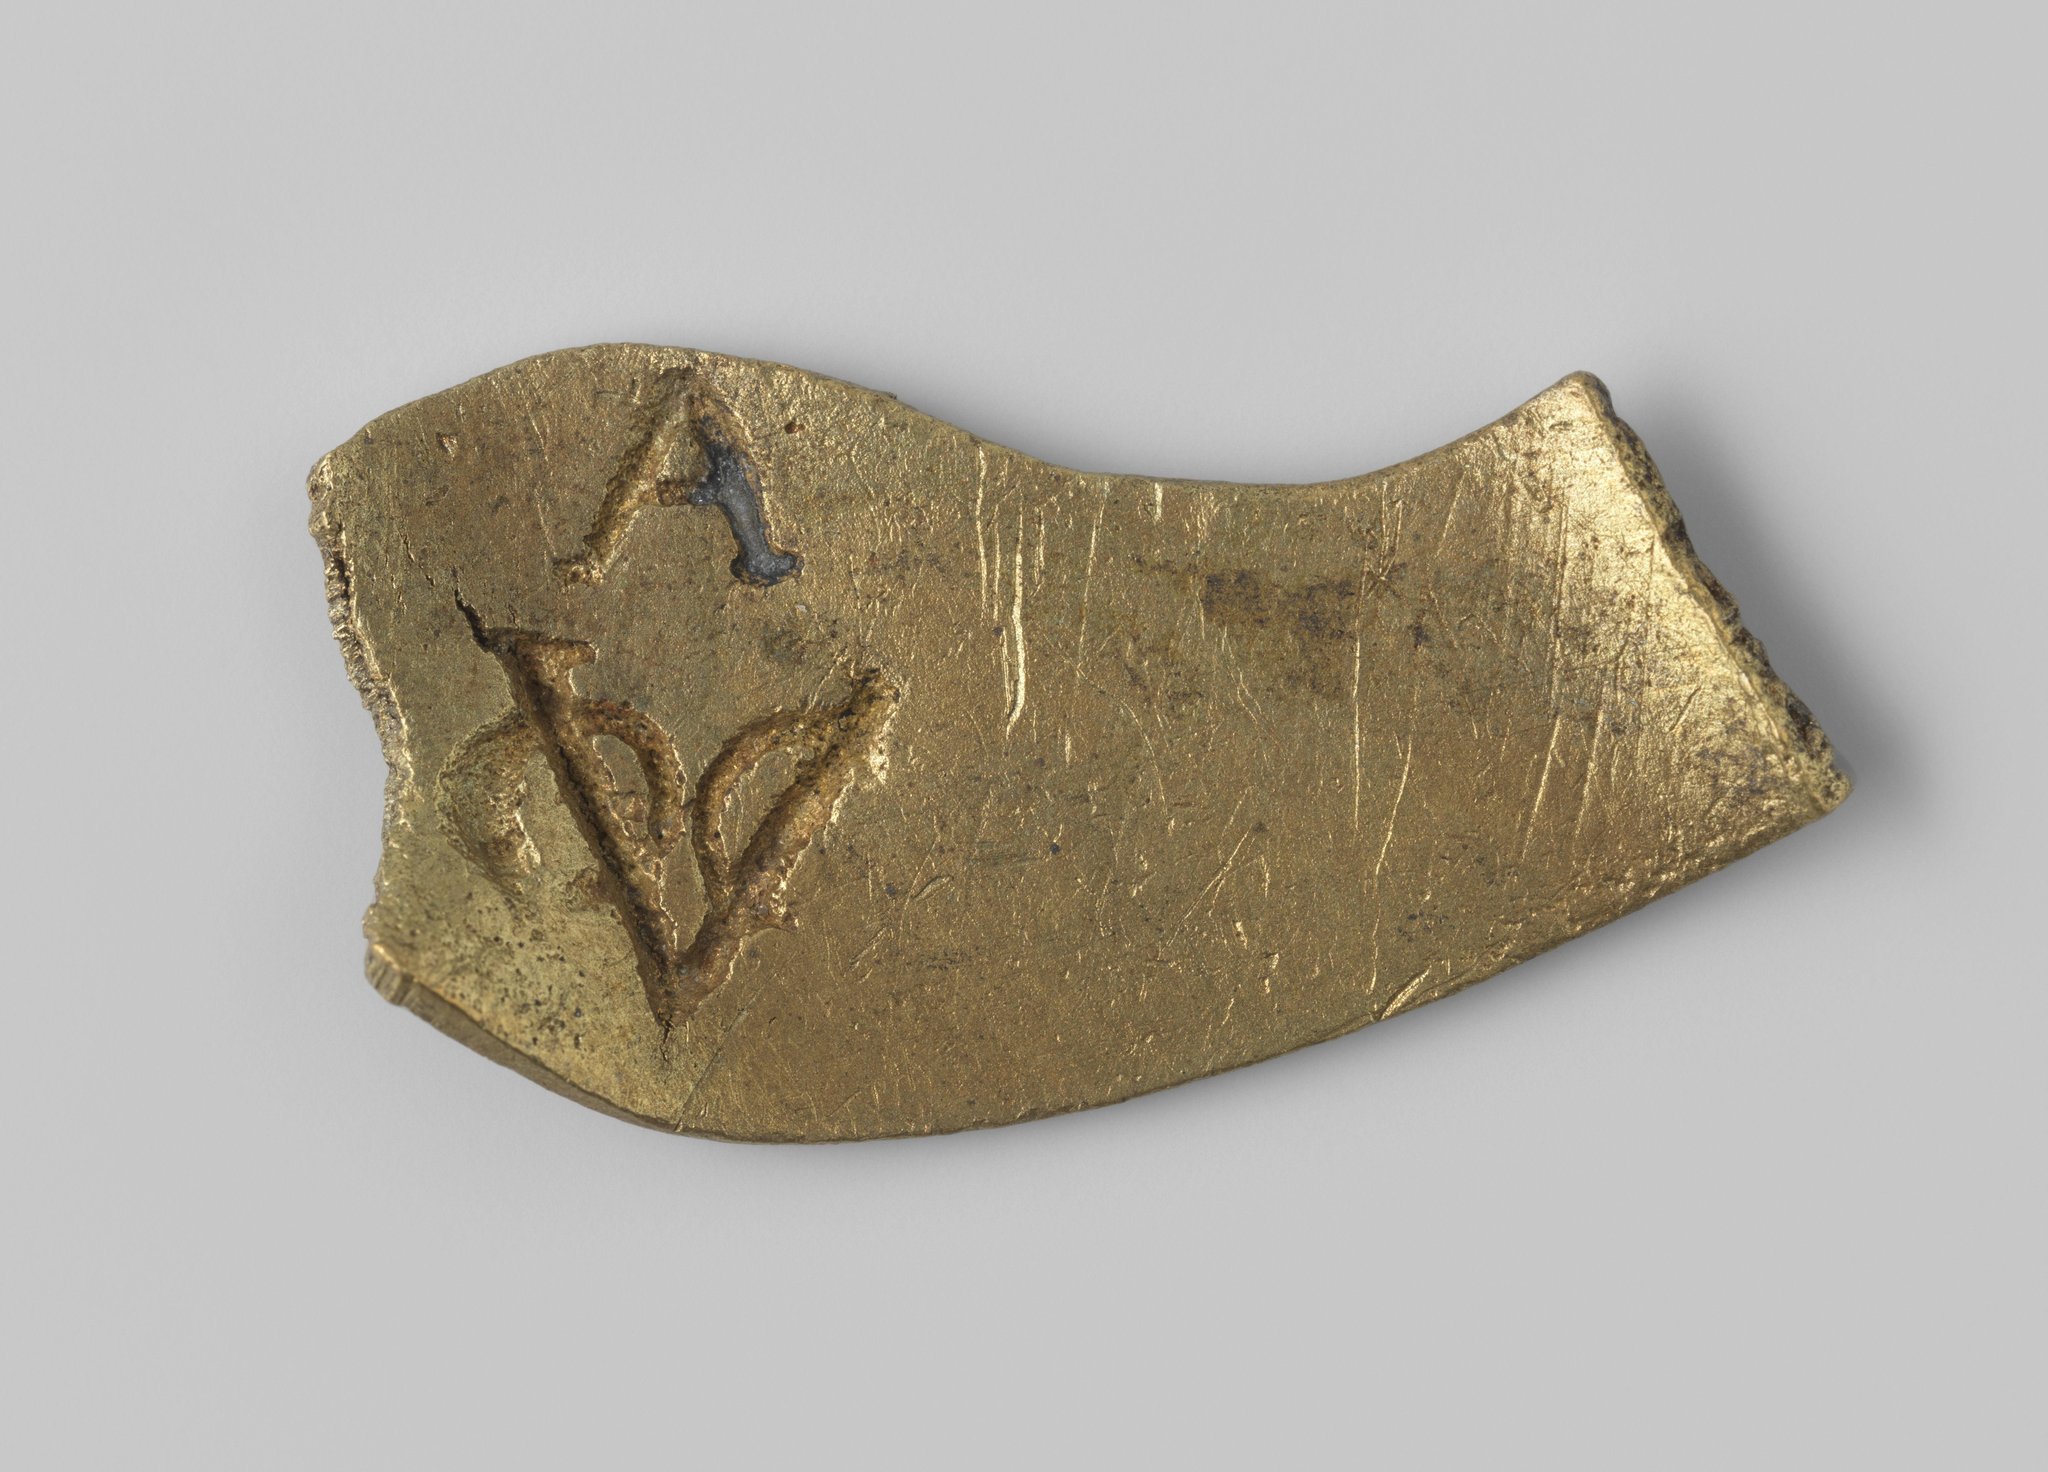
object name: musket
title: Fragment schroefplaat van een musket uit het wrak van de Oost-Indiëvaarder Hollandia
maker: Anonymous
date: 1700-1743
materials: copper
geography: netherlands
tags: verenigde oostindische compagnie, hollandia (schip), annet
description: Fragm of right wing id. NG 1978-74H986 or NG 1980-27H3069, side plate.